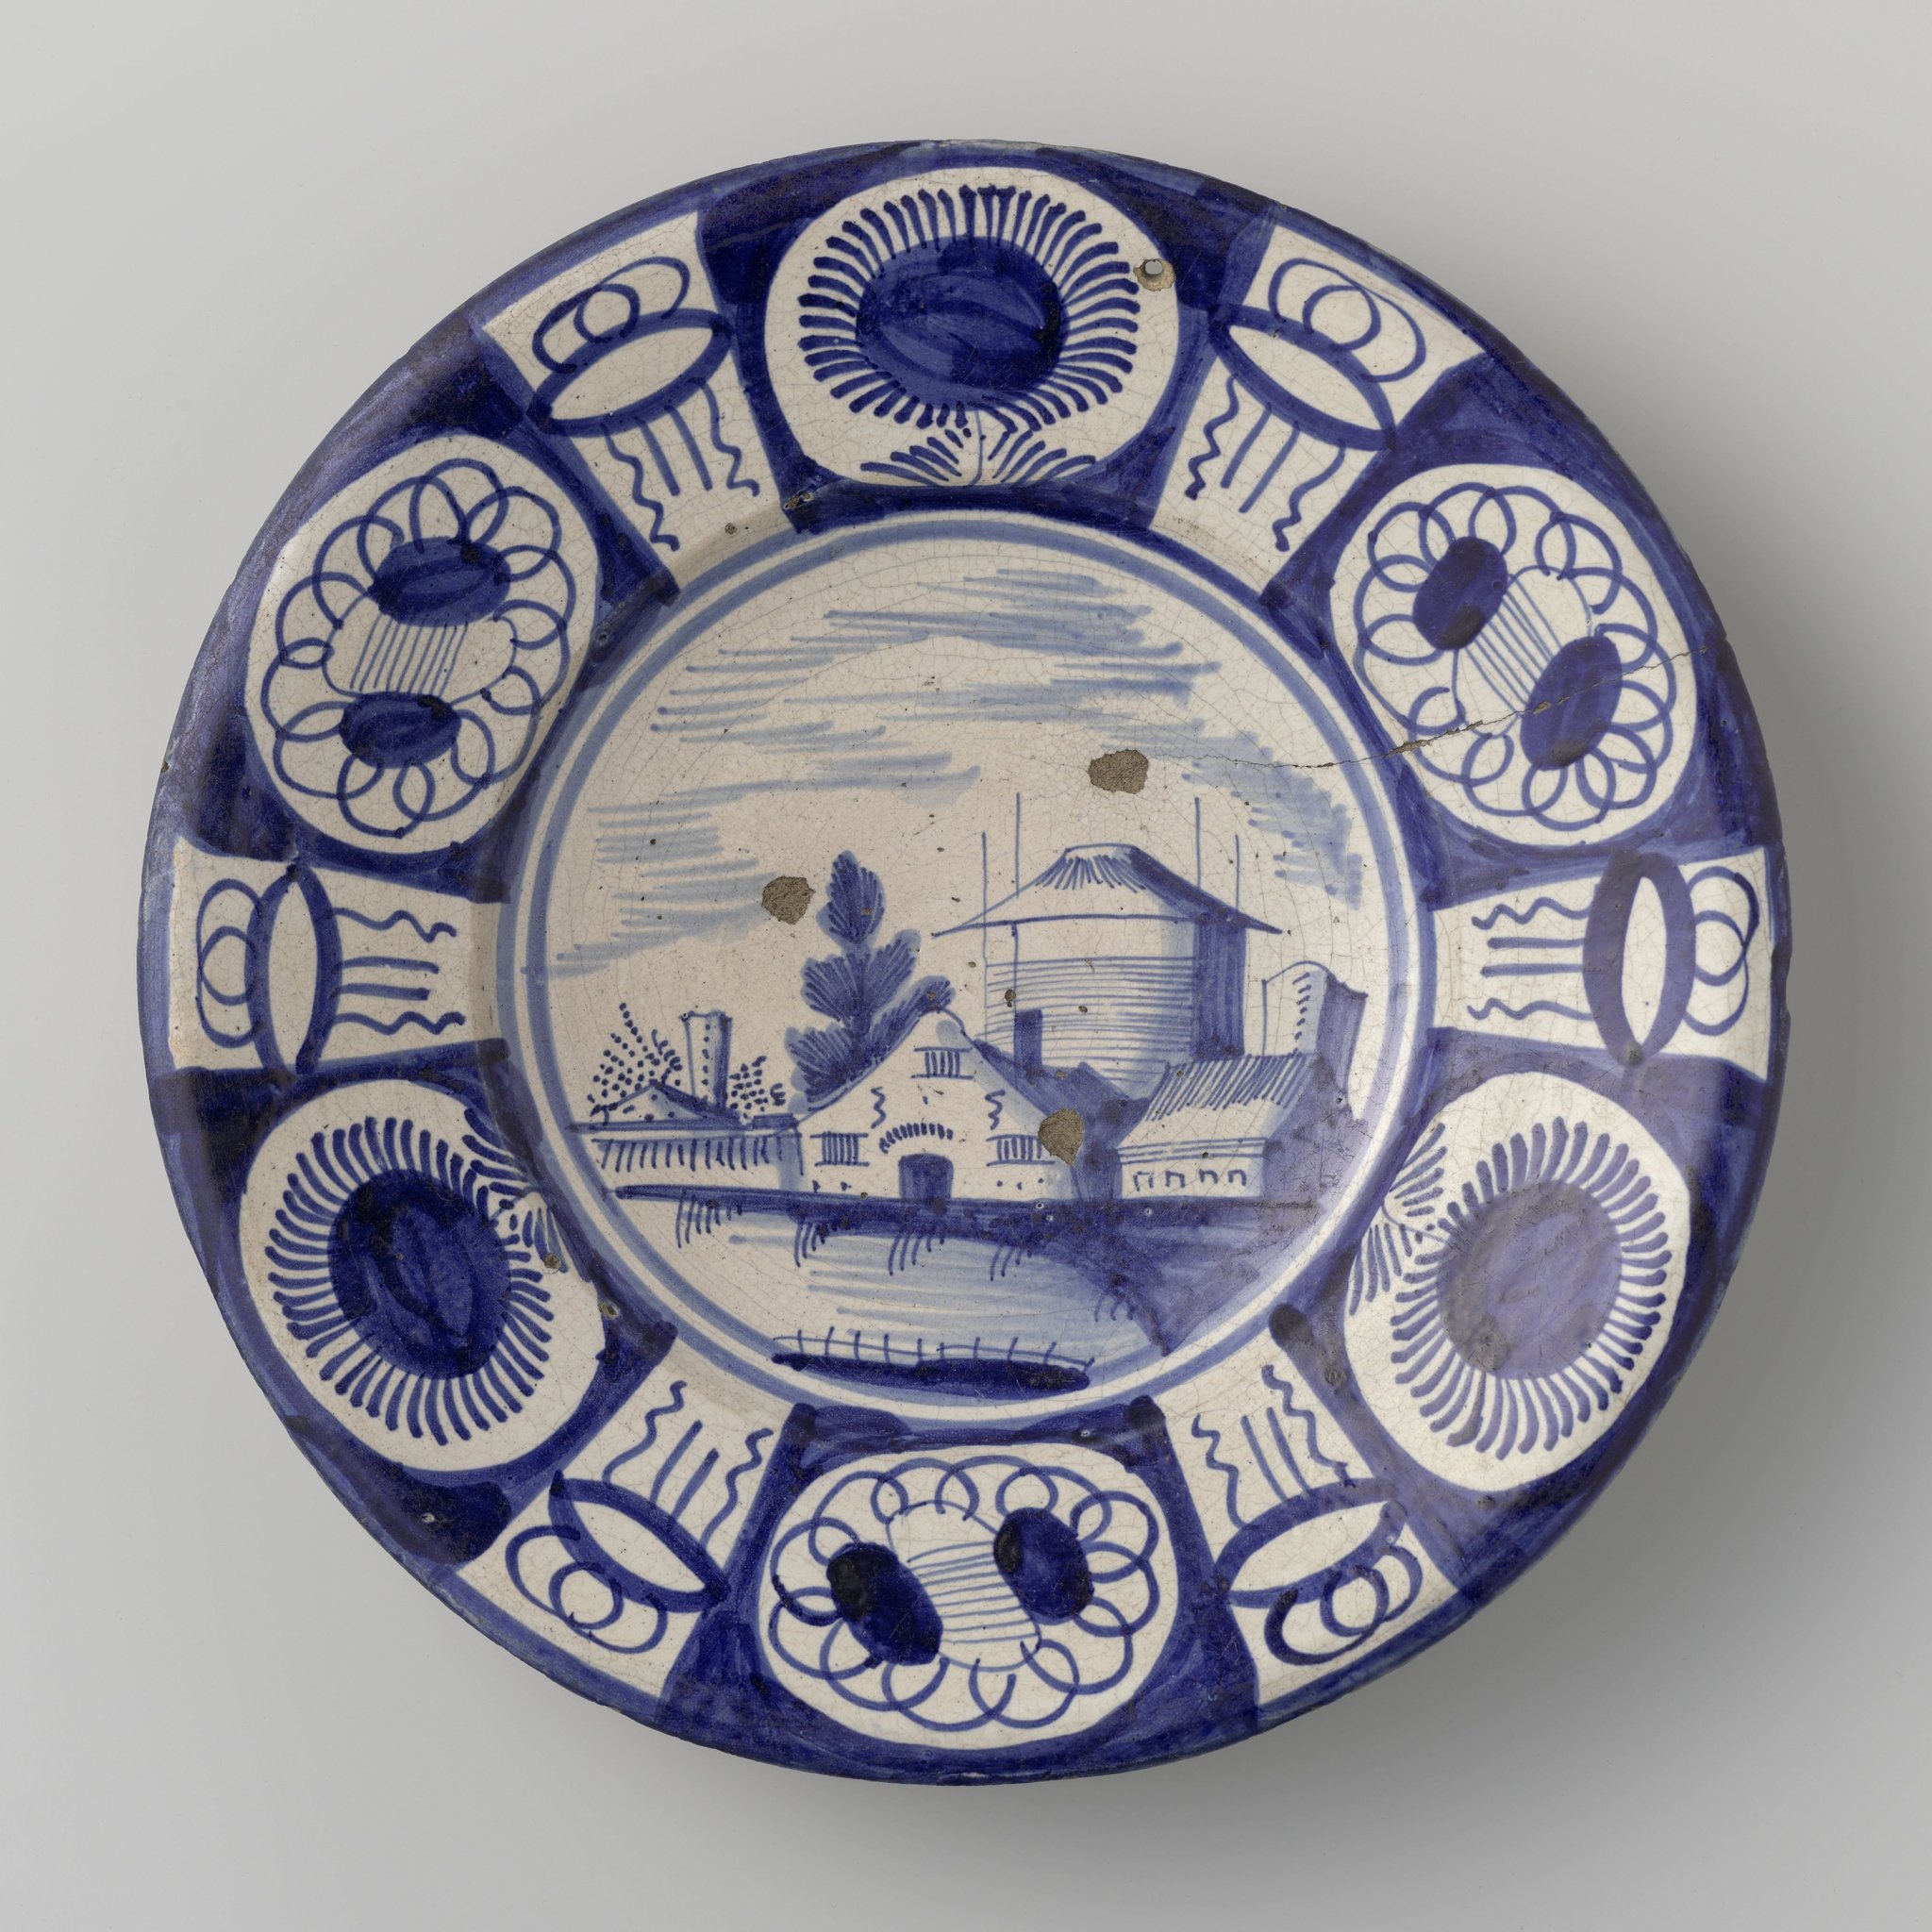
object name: platter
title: Ronde schotel van blauw beschilderde majolica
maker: Anonymous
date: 1630-1650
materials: earthenware, glaze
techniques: maiolica, painted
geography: netherlands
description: Dish, c. 1630 - 1650